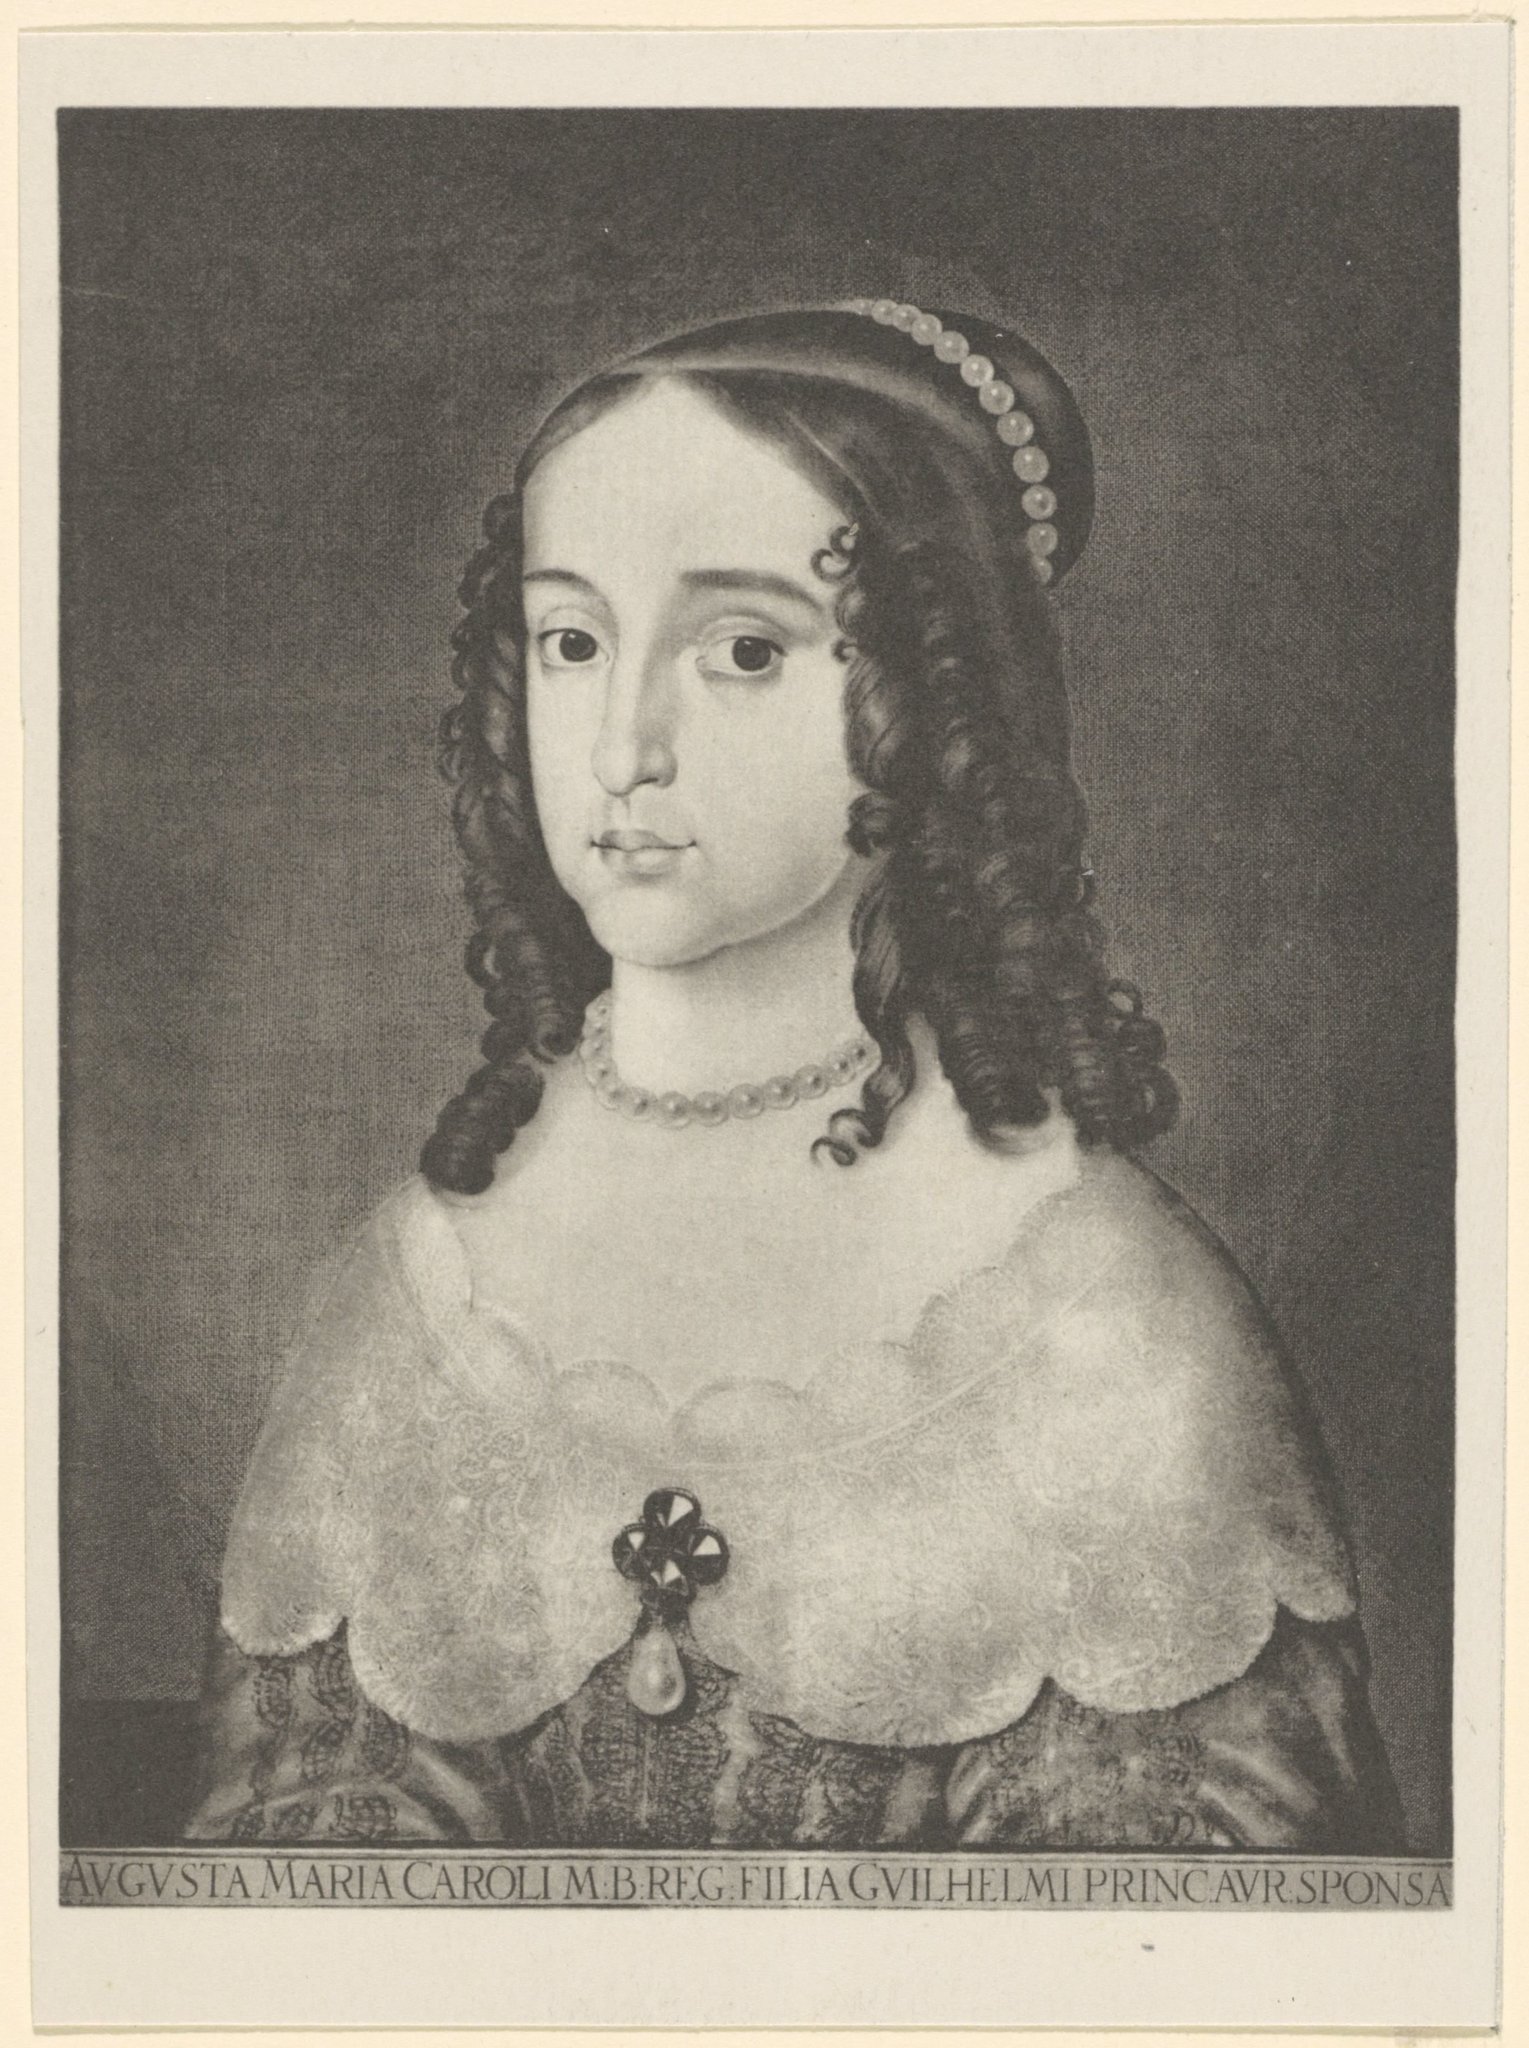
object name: photomechanical print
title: Portret van Maria Henrietta Stuart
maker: Anonymous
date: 1850-1949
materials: paper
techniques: photograph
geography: netherlands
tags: london, mary henrietta stuart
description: Portret van Maria Henrietta. In een kader een regel Nederlandse tekst.